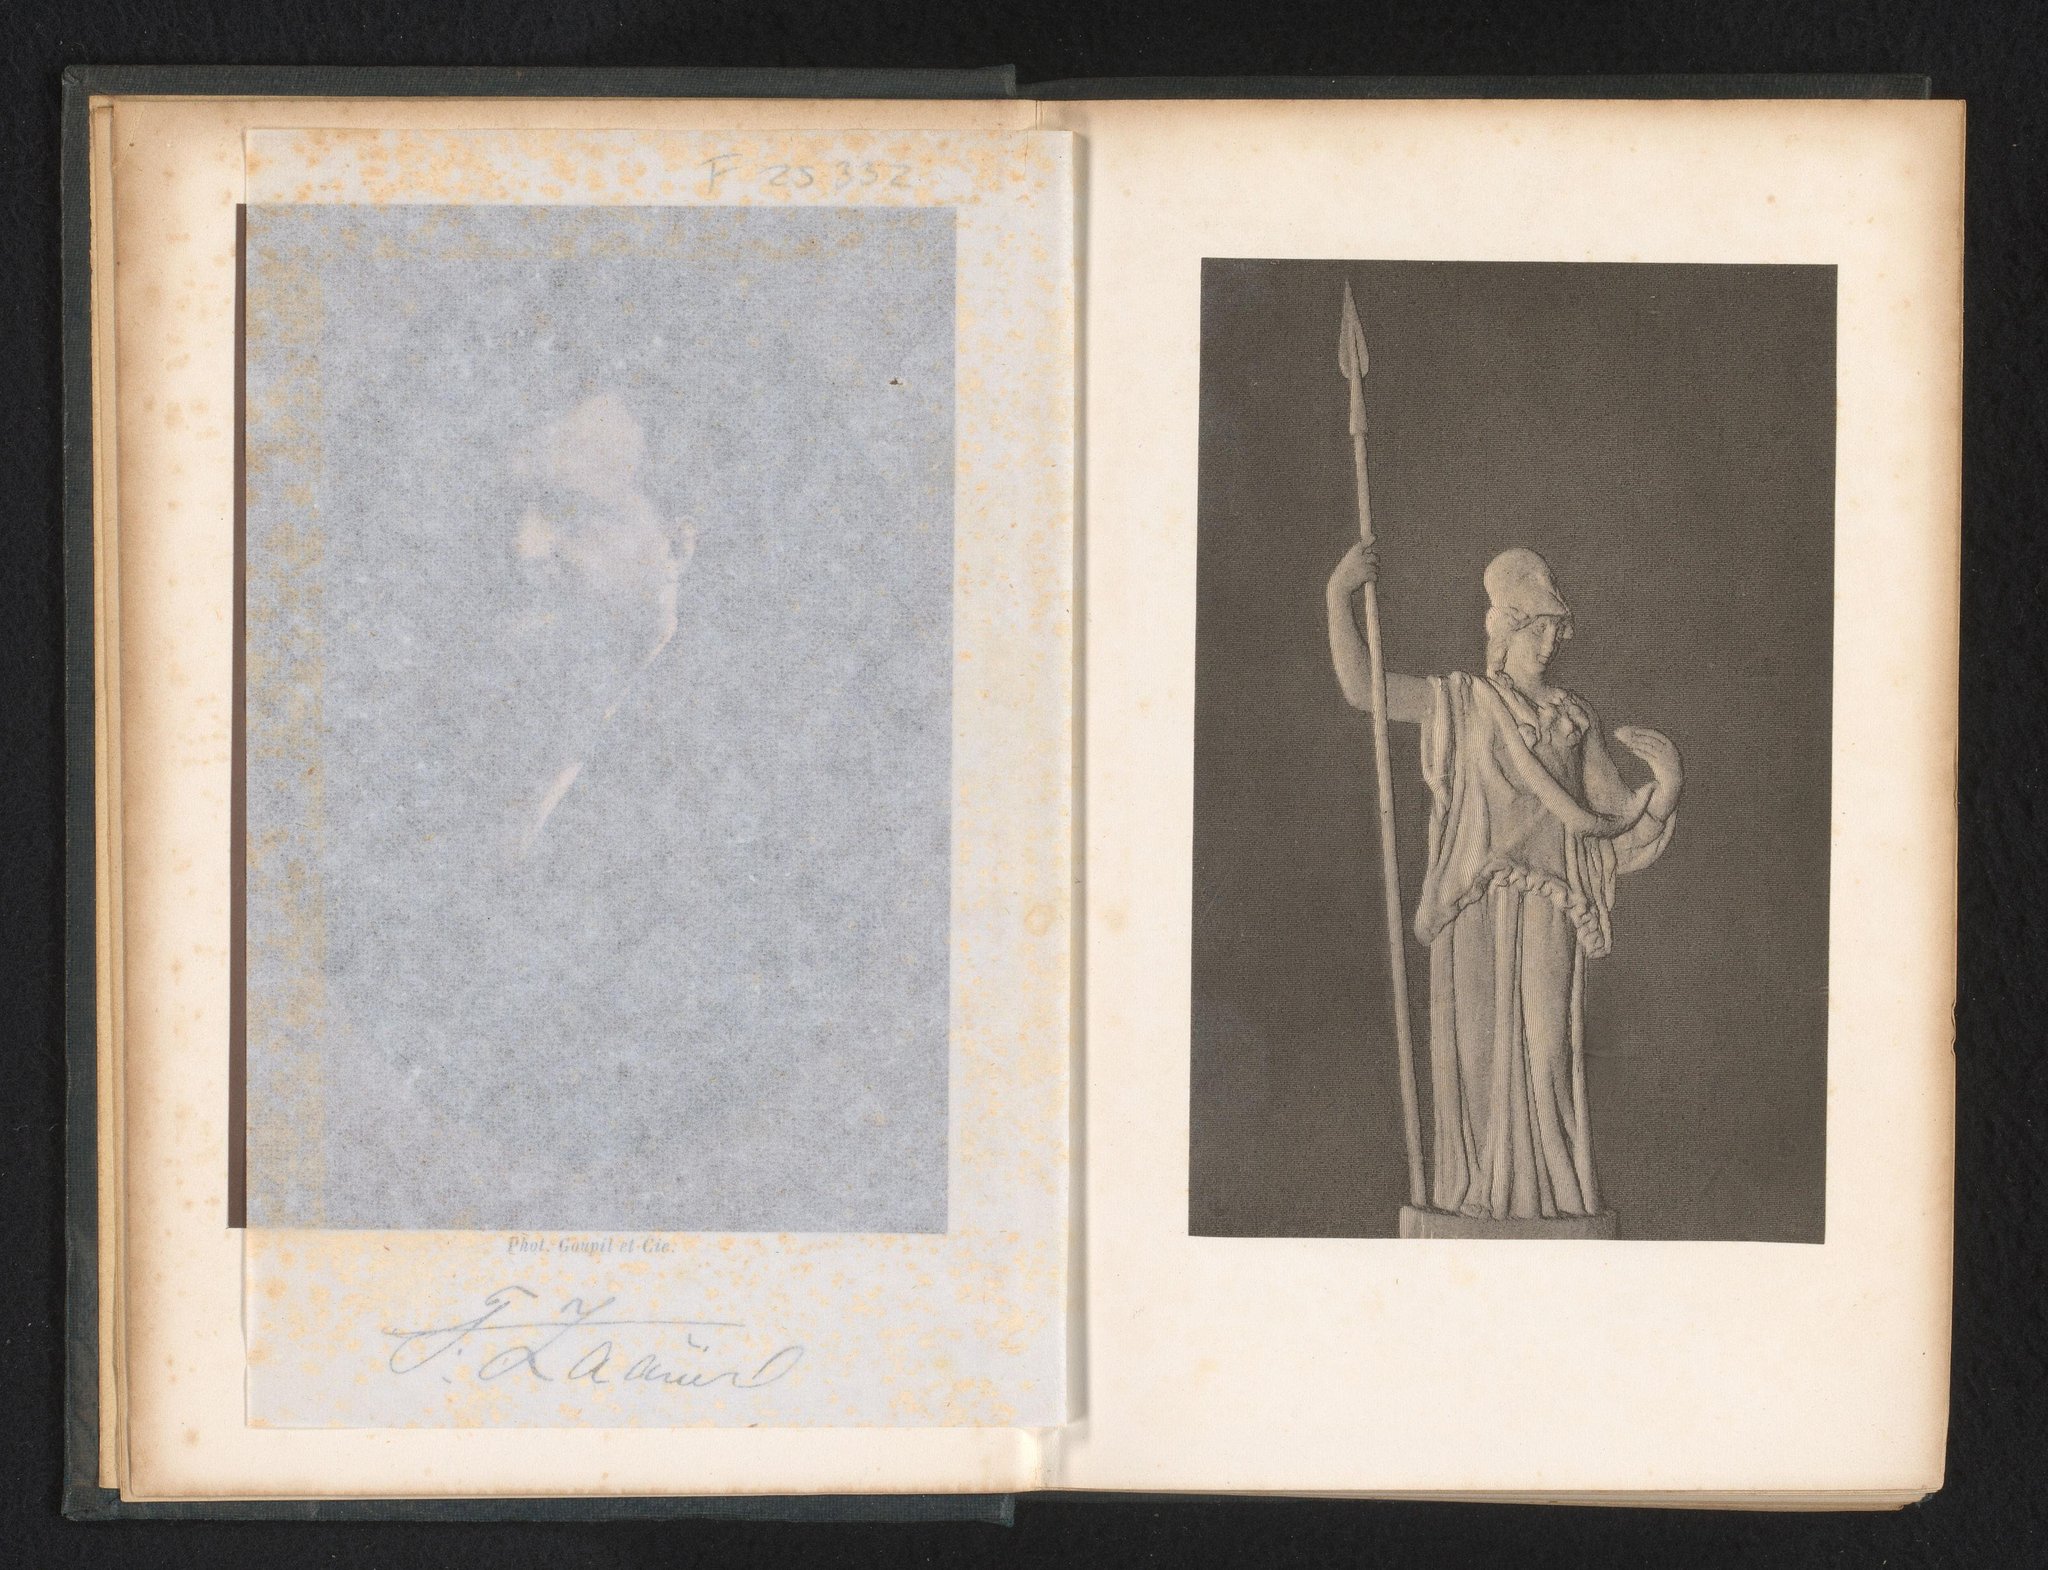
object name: reproduction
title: Fotoreproductie van een prent van de godin Minerva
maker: Anonymous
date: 1876-1881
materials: paper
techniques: gelatin silver print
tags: (story of) minerva (pallas, athena)